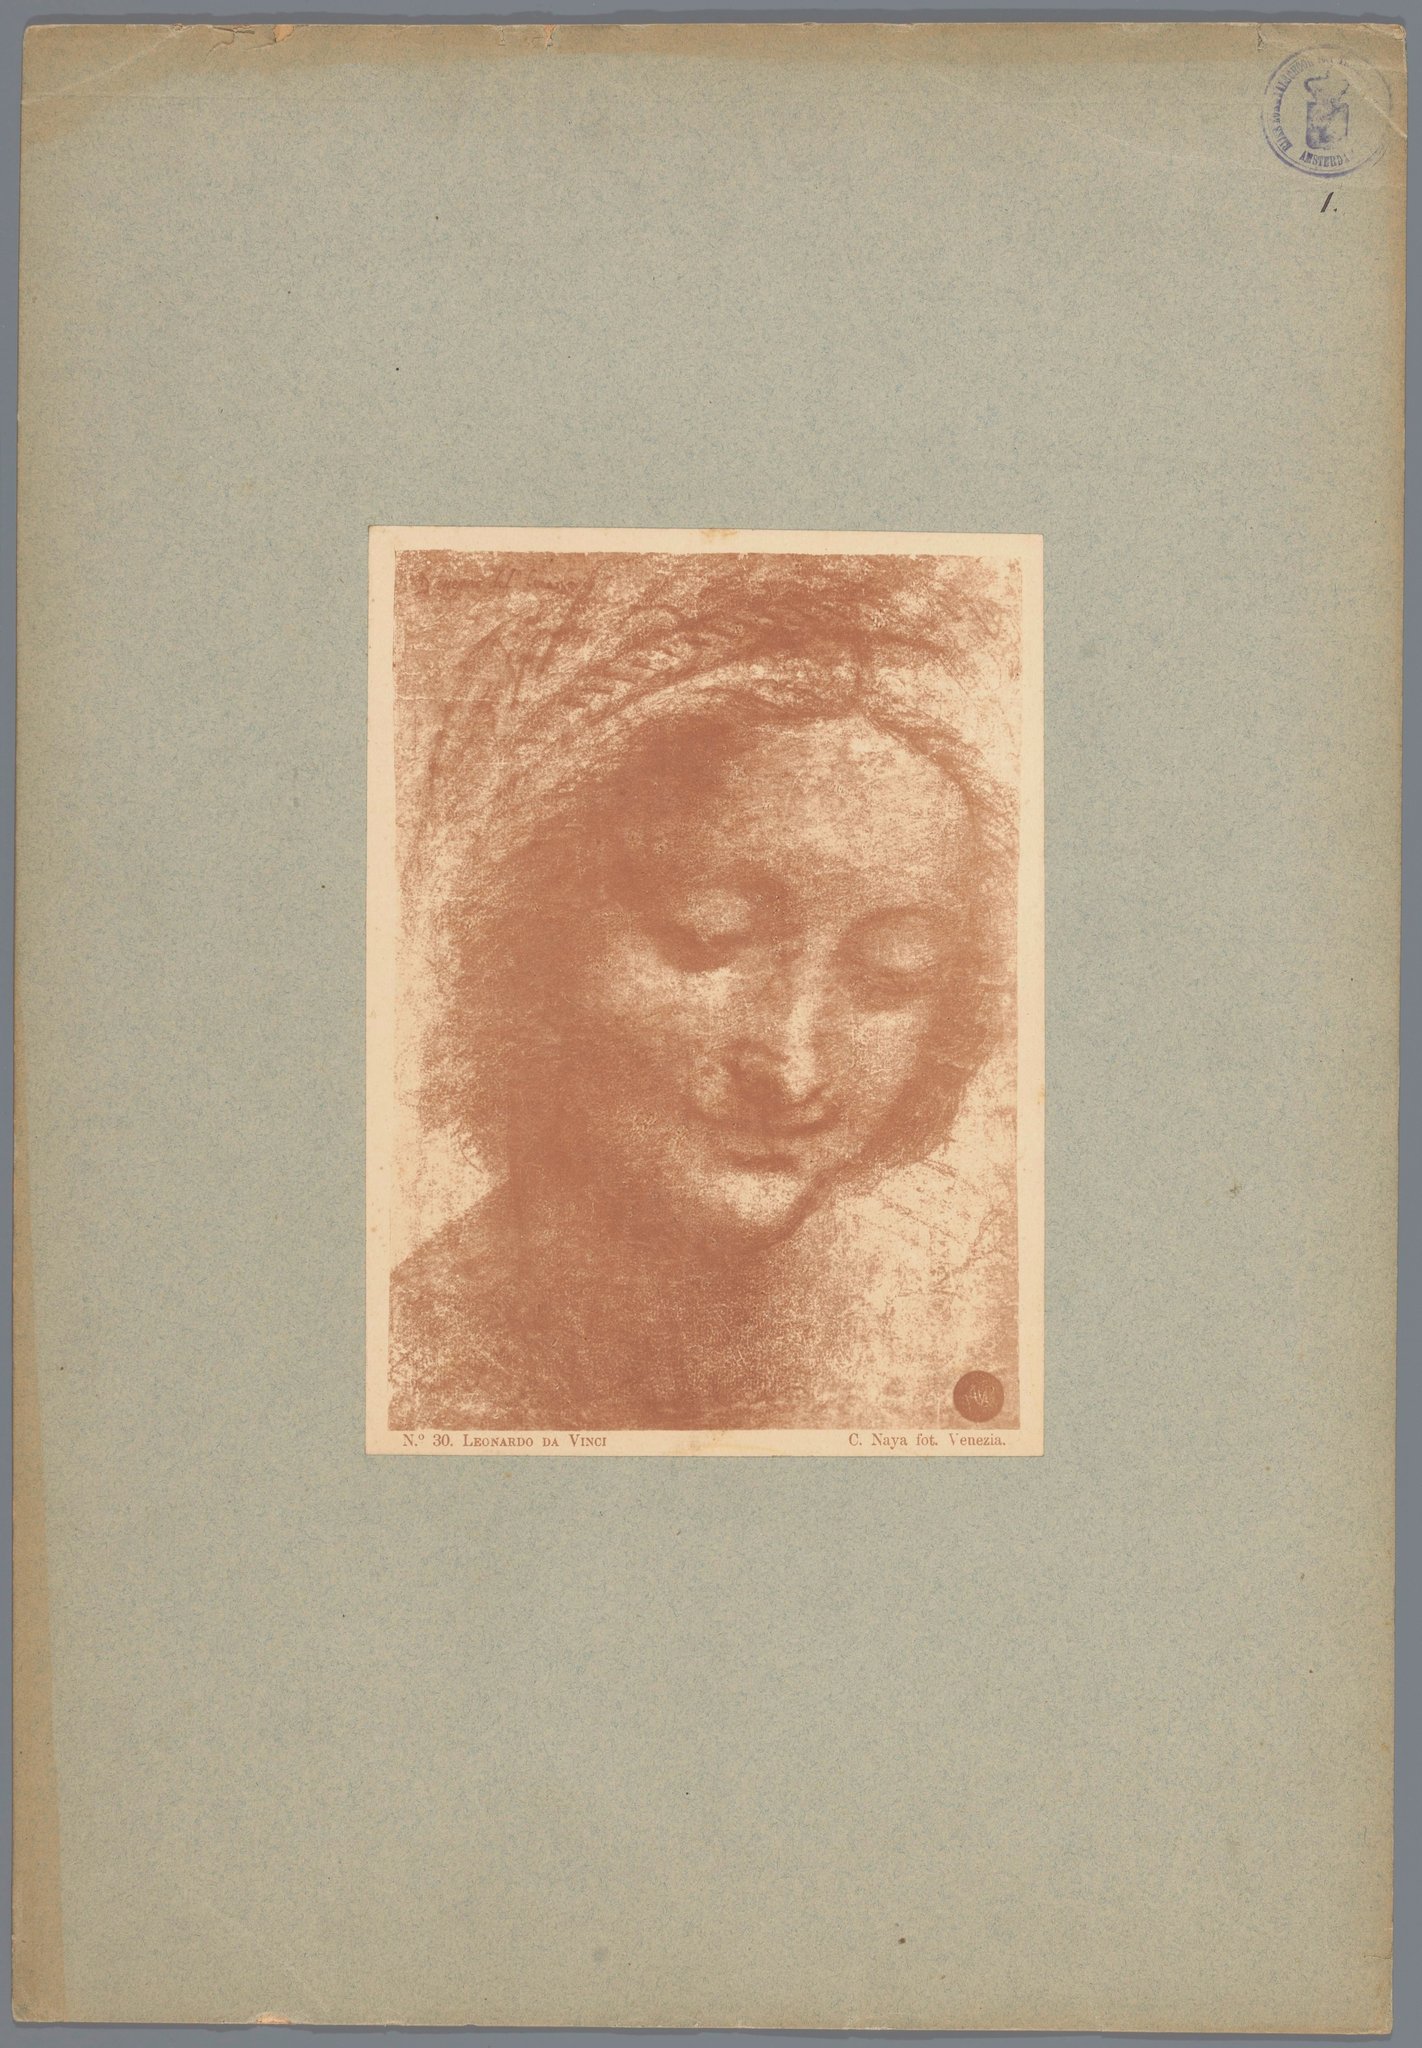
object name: reproduction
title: Leonardo da Vinci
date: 1875-1900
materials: cardboard, paper, ink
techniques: photograph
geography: venice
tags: anna, mother of mary; possible attributes: book, christ-child, lily, virgin mary, europe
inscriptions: collector's mark: ‘RIJKS-NORMAALSCHOOL voor TEEKENONDERWIJZERS AMSTERDAM’, number: ‘No. 30.’, collector's mark: ‘RIJKS-NORMAALSCHOOL voor TEEKENONDERWIJZERS AMSTERDAM’, name: ‘A[...]’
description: Arceringen in potlood zijn zichtbaar op het beeldvlak.